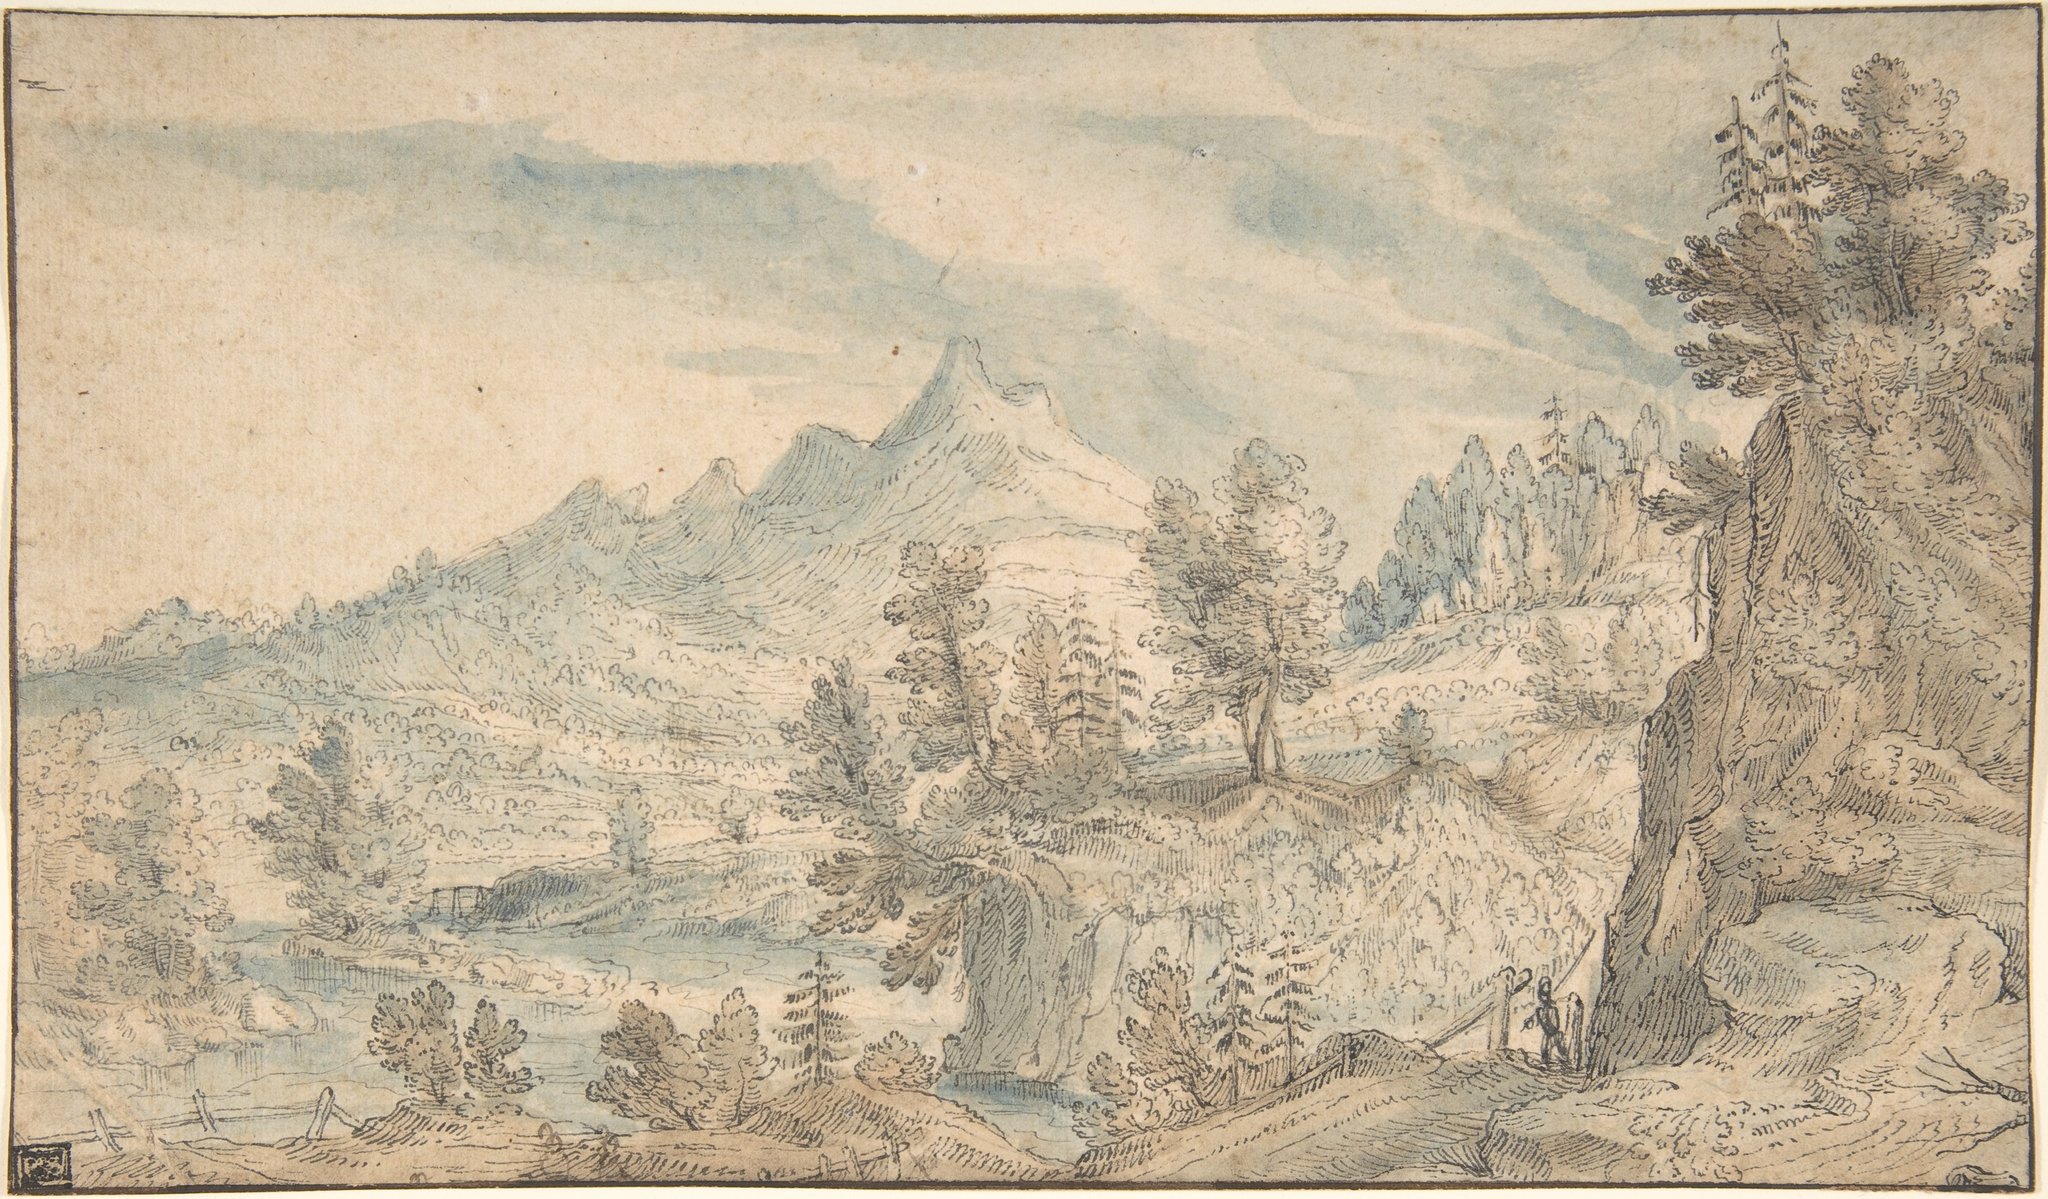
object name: drawing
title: The Salzach Valley with a View of the Watzmann Massif in the Background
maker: frederik van valkenborch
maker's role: artist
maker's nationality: netherlandish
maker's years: 1566-1623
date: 1595-1600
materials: ink, watercolor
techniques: brush, pen, wash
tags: mountains,landscapes,trees